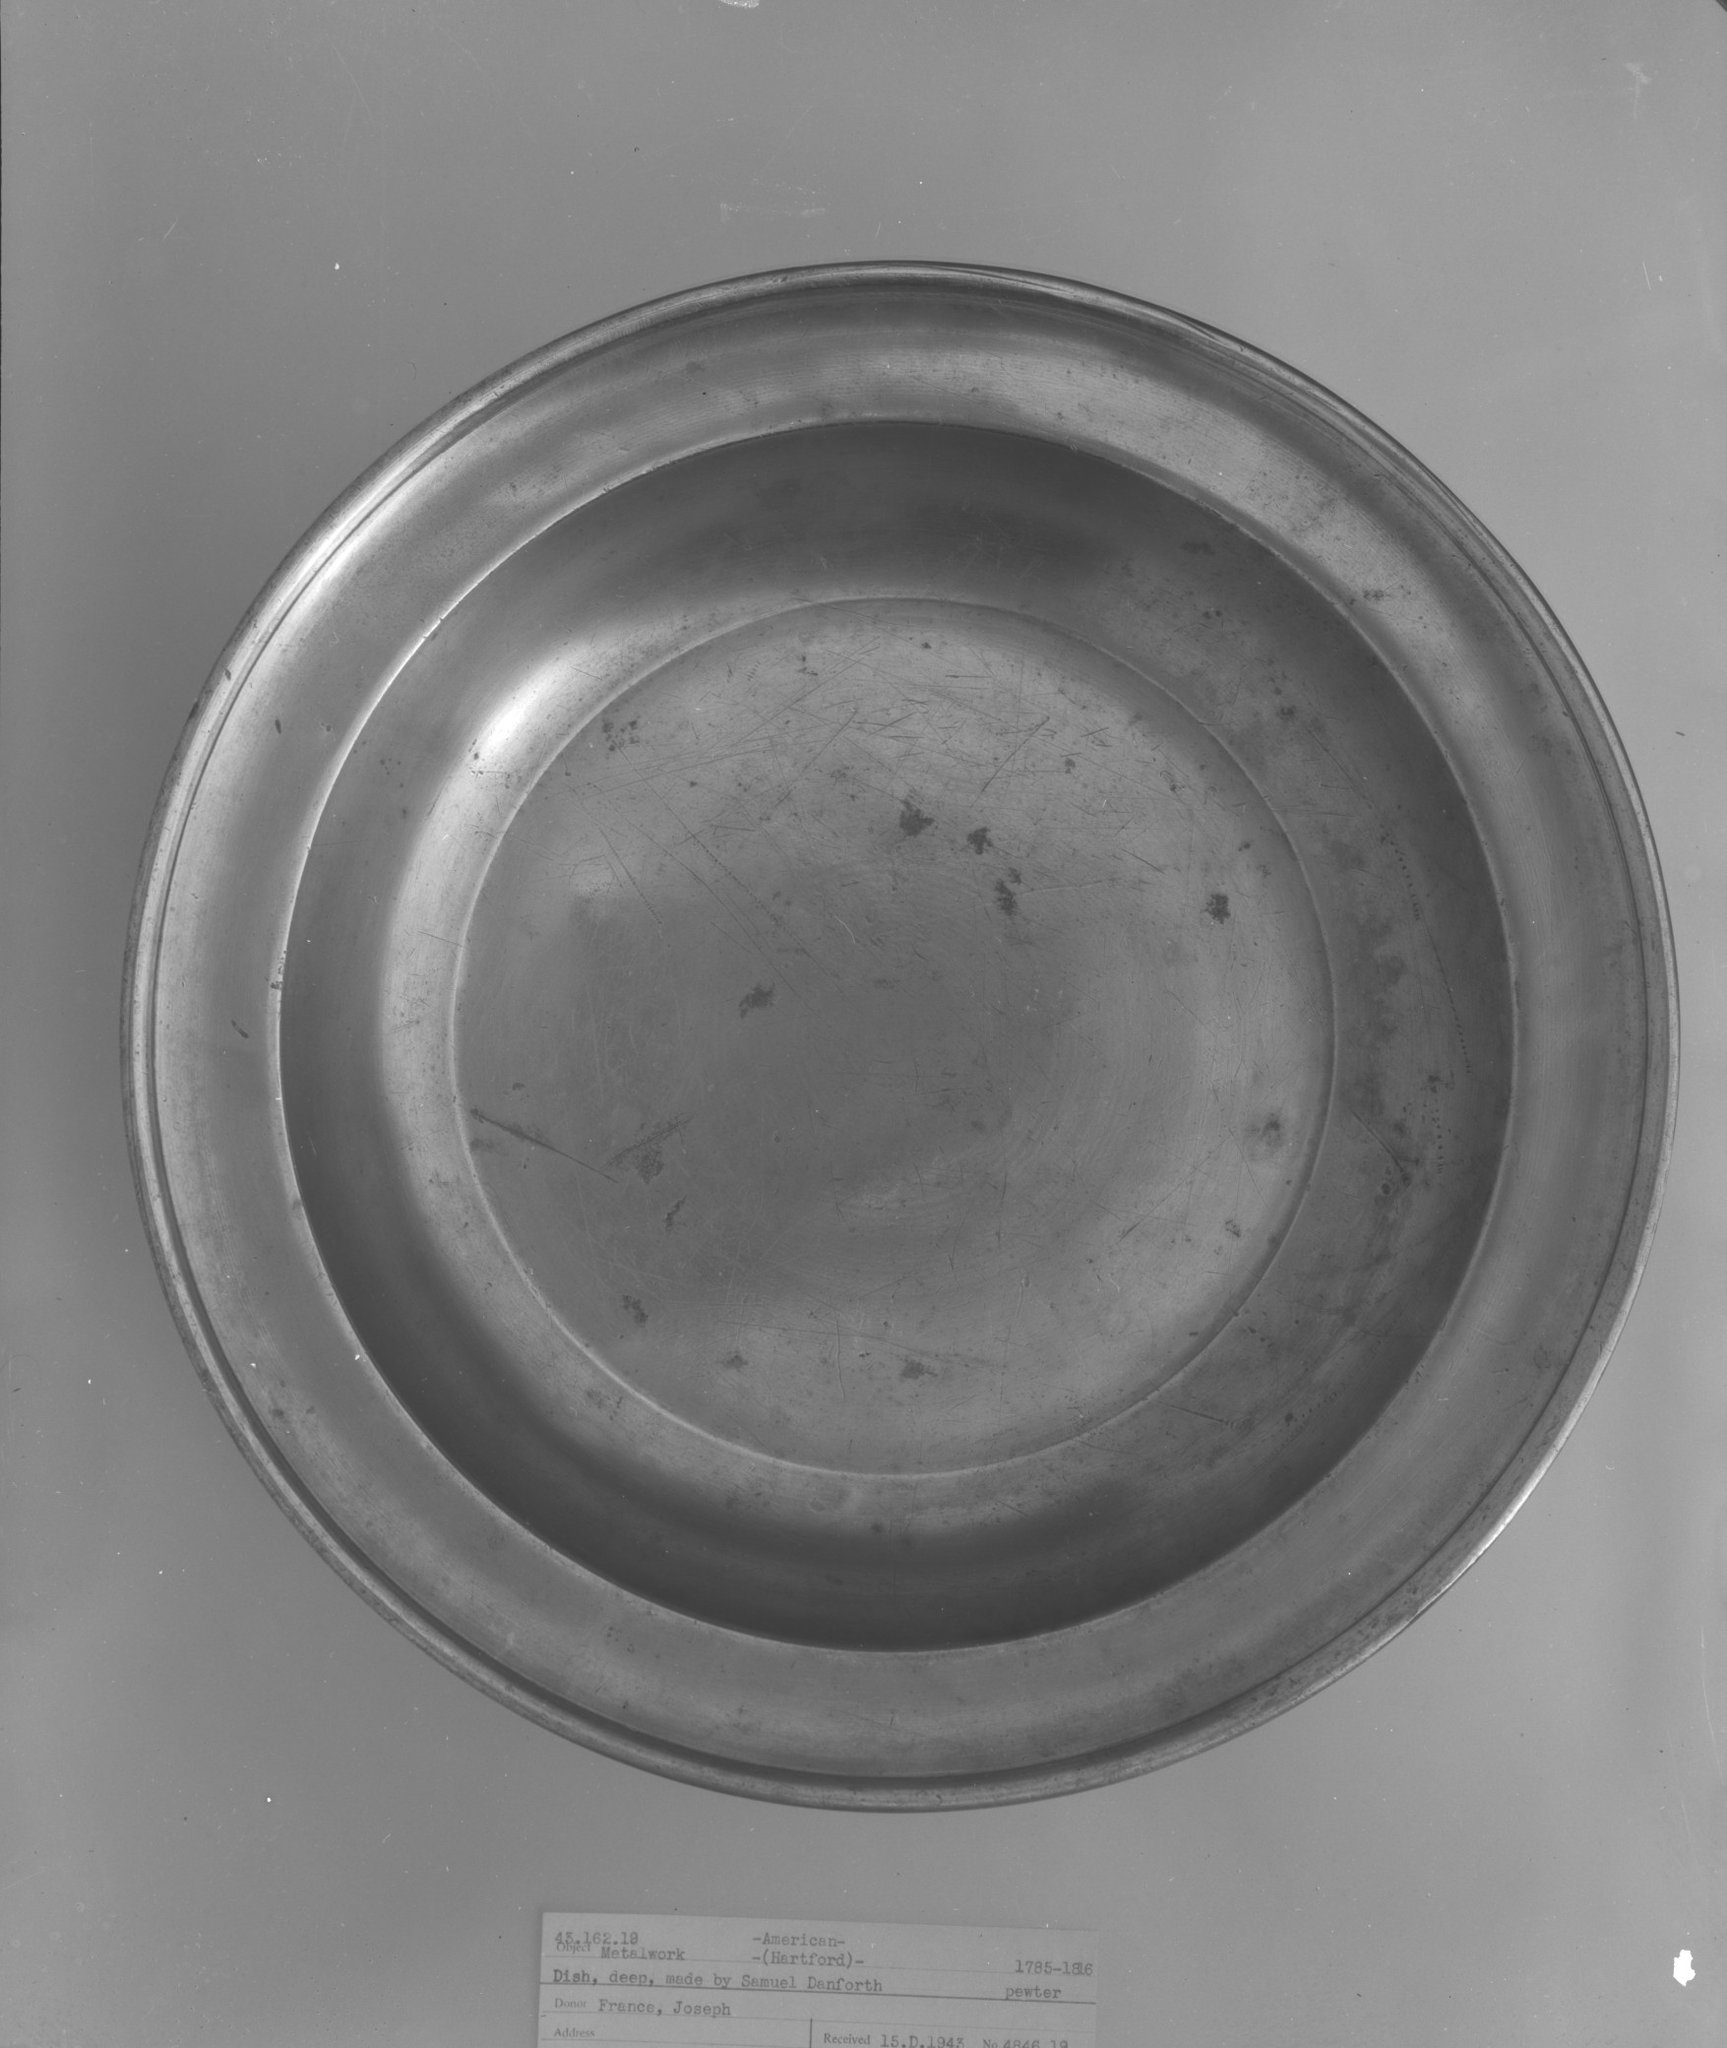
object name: dish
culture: american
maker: samuel danforth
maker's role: maker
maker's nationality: american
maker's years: 1774-1816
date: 1795-1816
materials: pewter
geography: united states